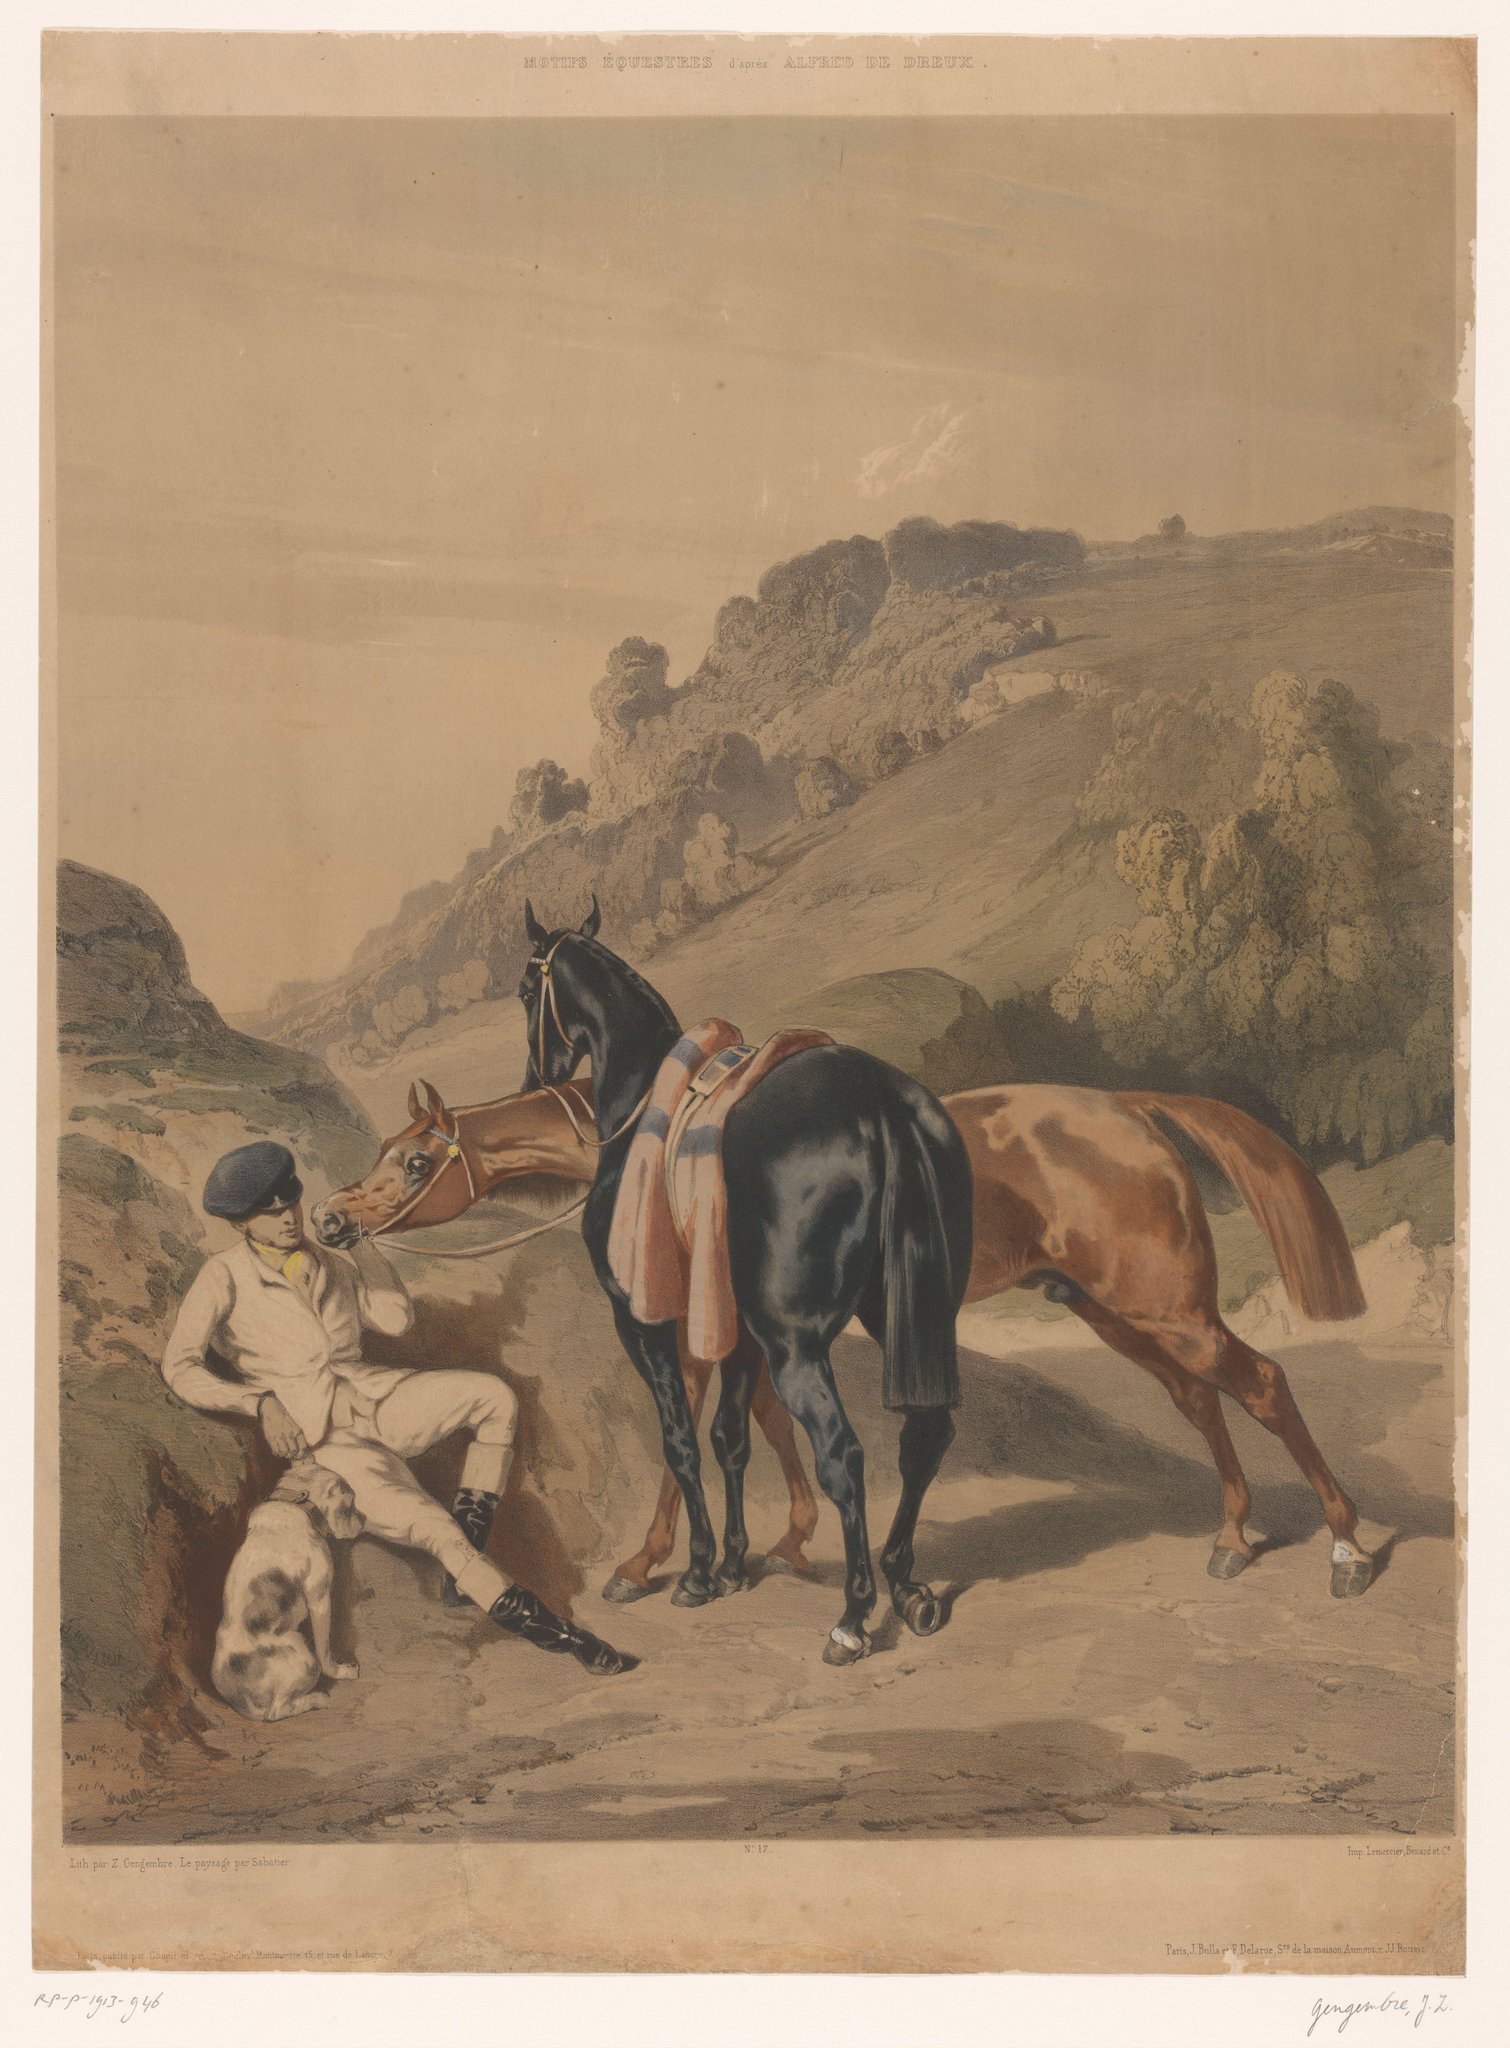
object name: print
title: Motifs équestres d'après Alfred de Dreux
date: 1835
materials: paper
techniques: hand coloring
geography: paris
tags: riding a horse, ass, or mule; rider, horseman, horse, resting - bb - out of doors